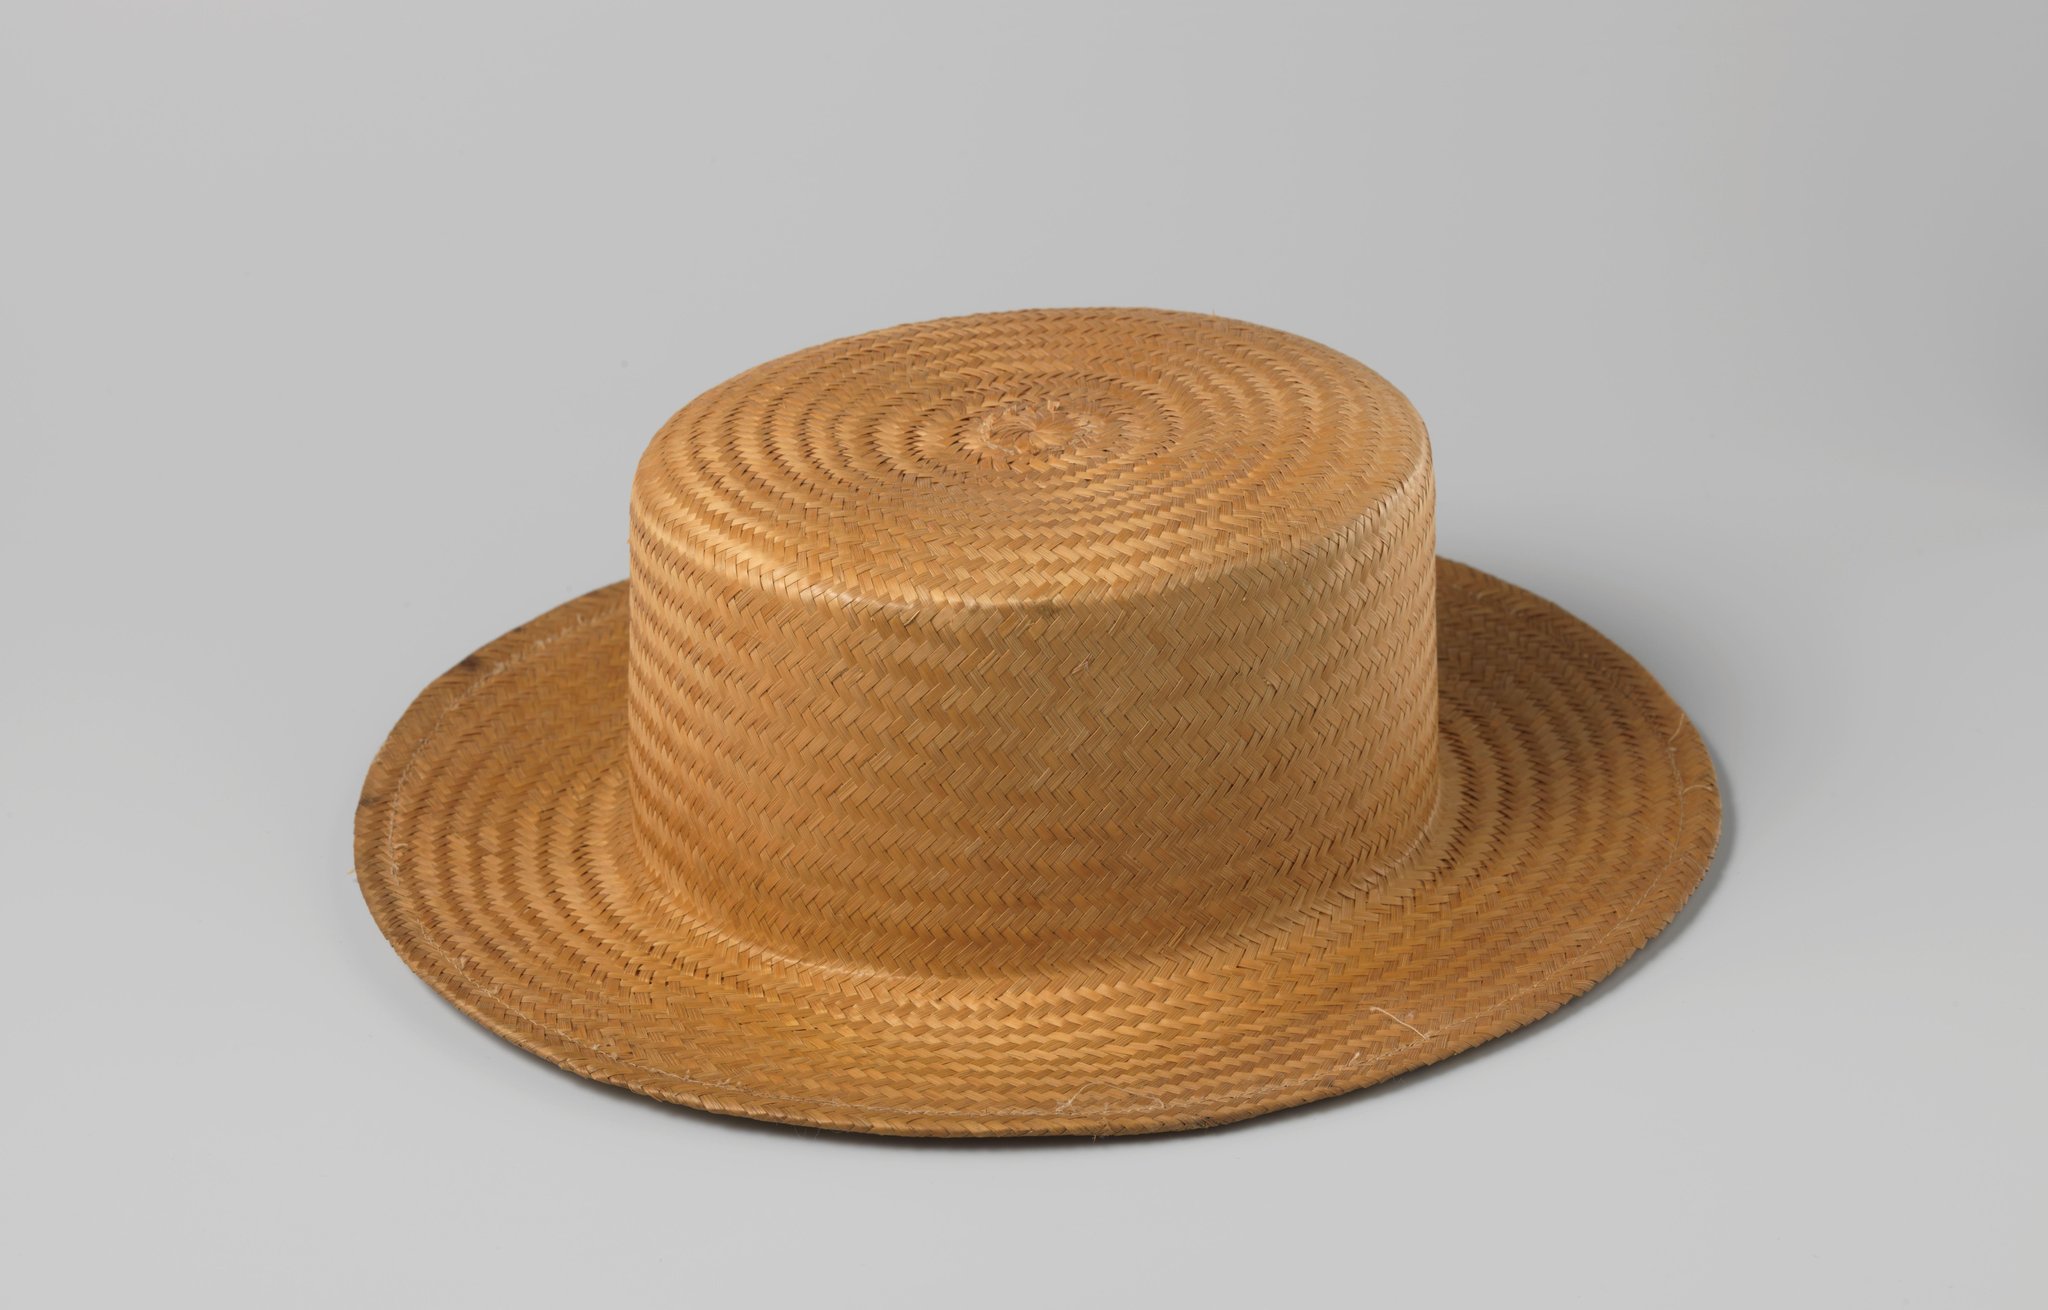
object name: straw hat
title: Strohoed, hoog ovaal model, ongevoerd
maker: Anonymous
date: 1900-1930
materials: straw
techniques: braiding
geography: paris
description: Strohoed, hoog ovaal model met platte bodem, ongevoerd en zonder lint. De rand is omgezoomd.